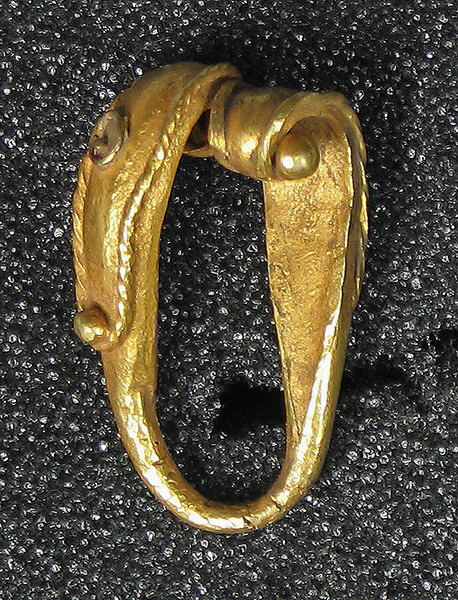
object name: earring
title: Double Scroll Fertility Earring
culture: indonesian, central java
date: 701-1200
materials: gold